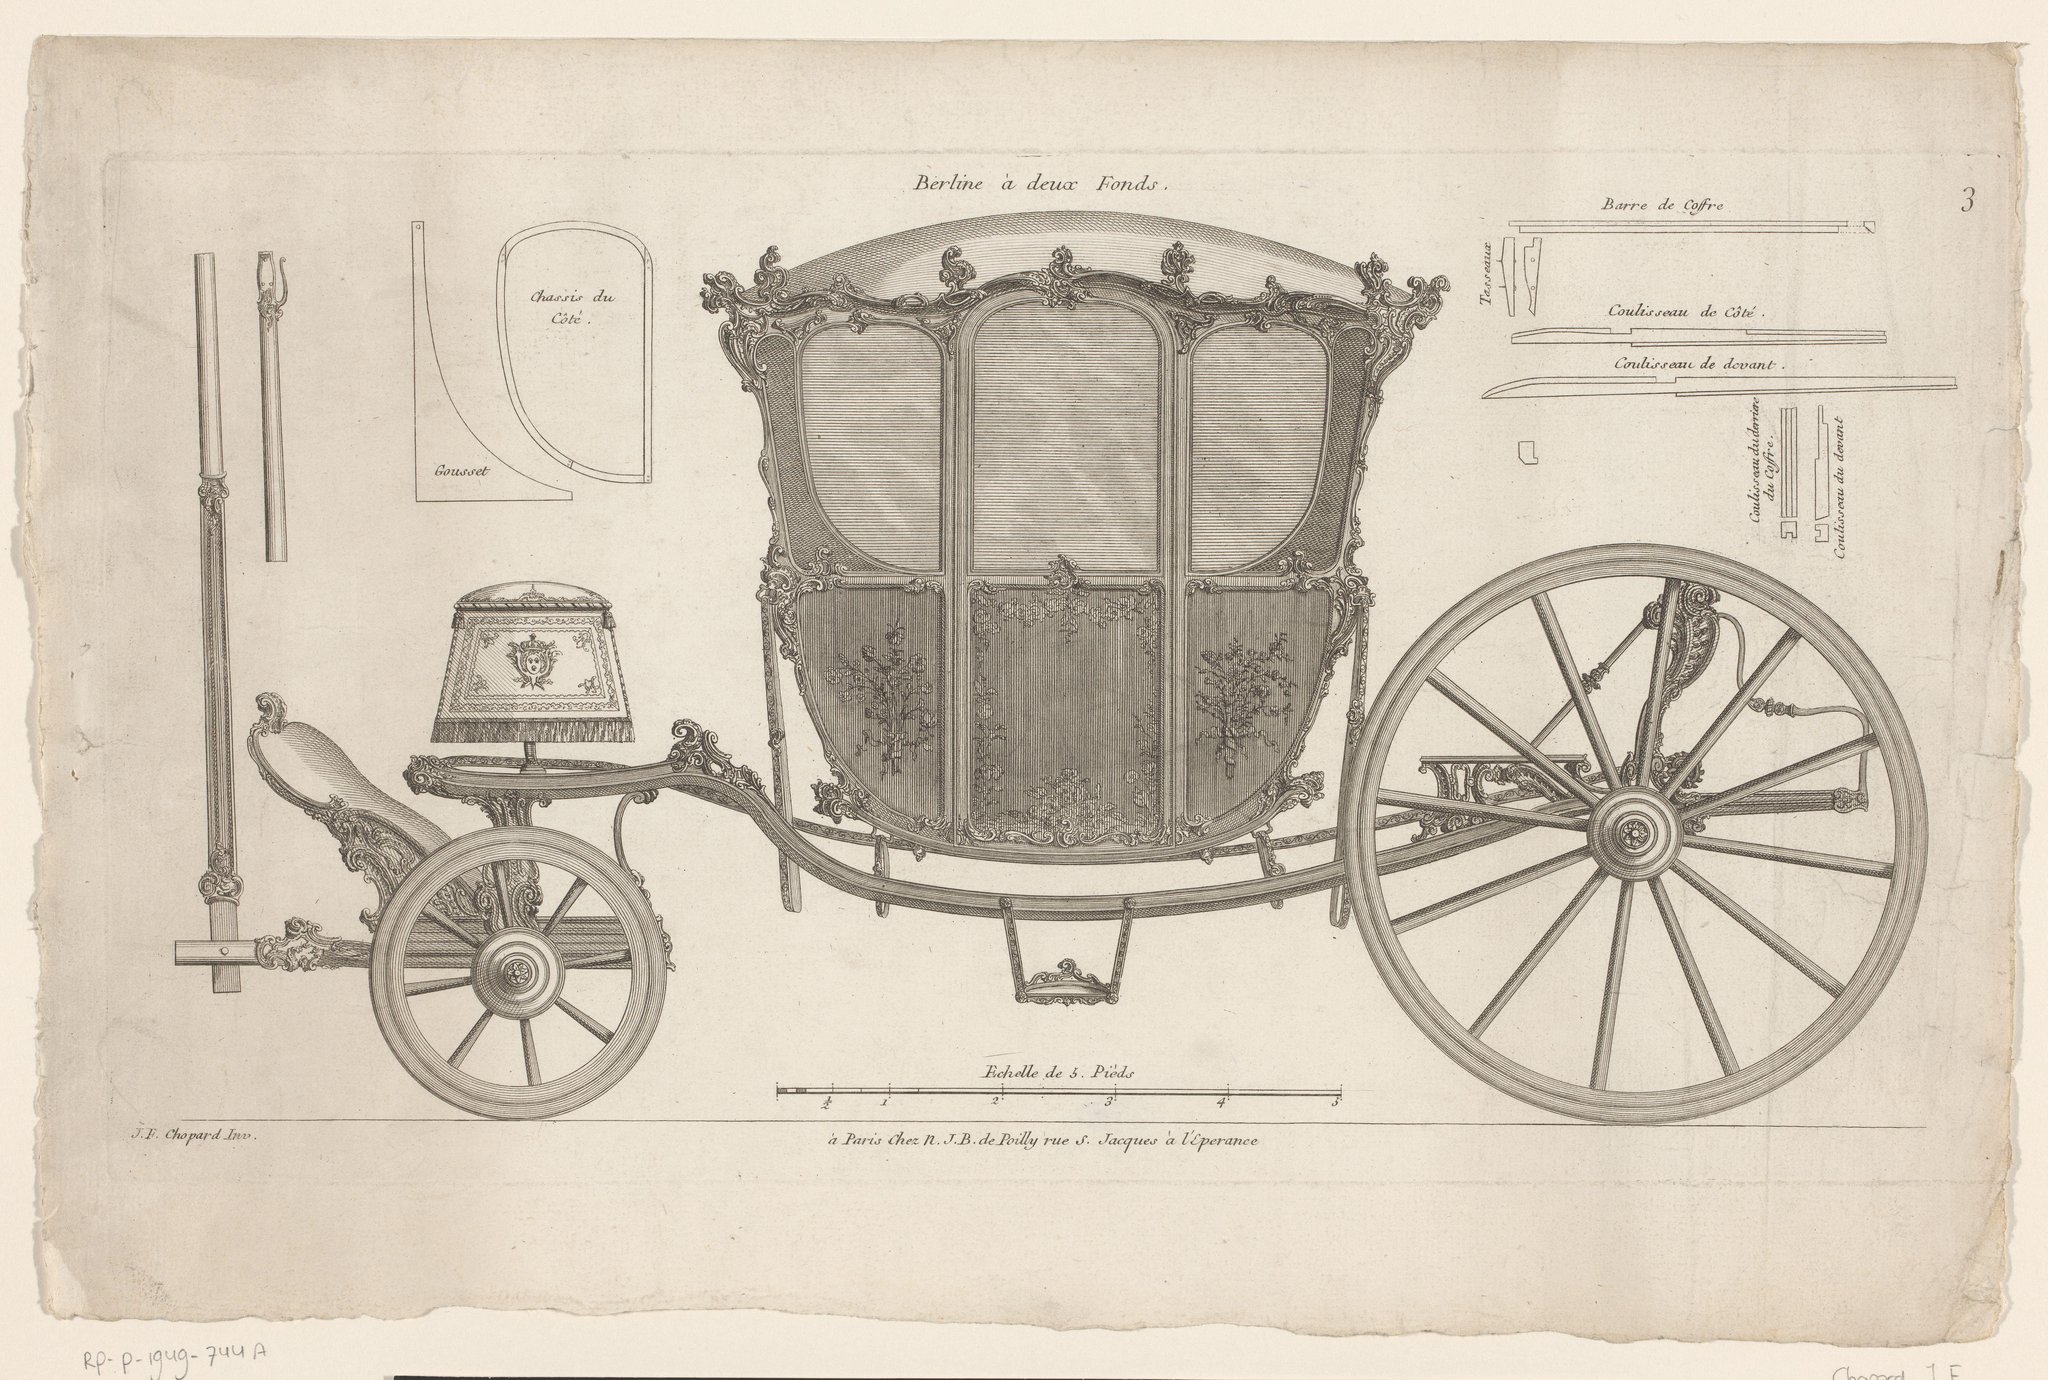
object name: ornament print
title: Modèles de voitures Louis XV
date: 1740-1758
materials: paper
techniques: engraving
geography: paris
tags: four-wheeled, animal-drawn vehicle, e.g.: cab, carriage, coach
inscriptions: collector's mark: Lugt 2228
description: Een berline is een gesloten reiskoets voor vier personen.